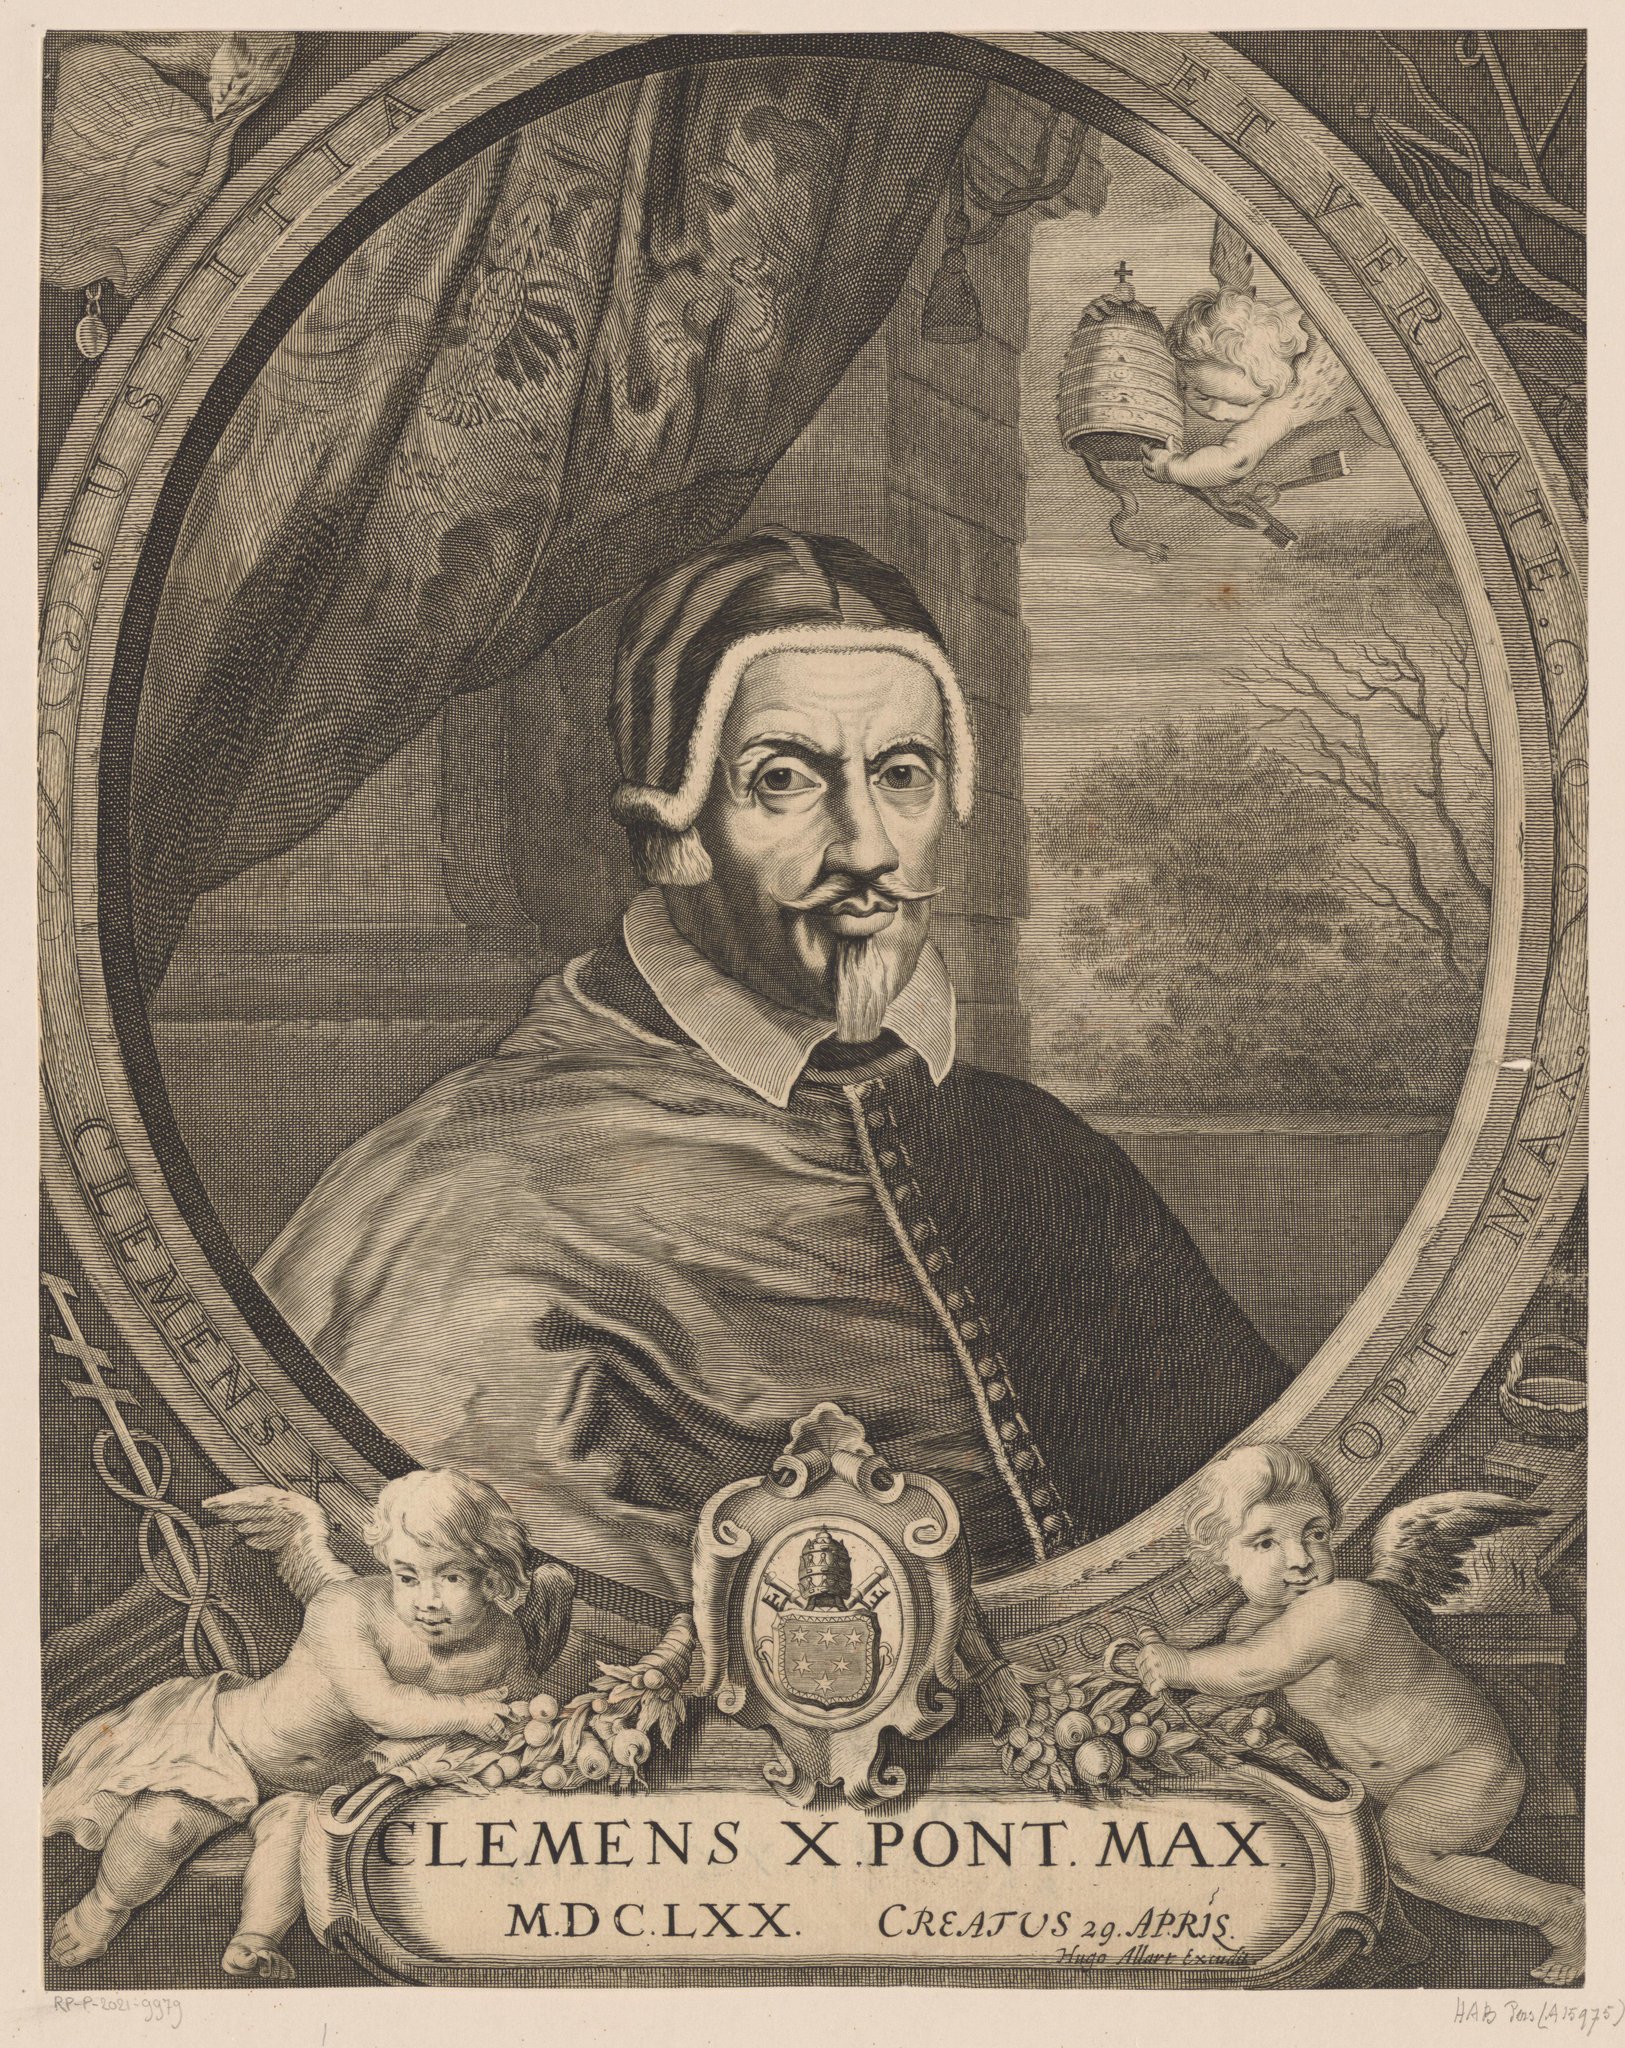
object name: print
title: Portret van Clemens X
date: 1670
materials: paper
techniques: engraving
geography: amsterdam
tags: clemens x, pope - pp - antipope, historical persons, pope, cupids: 'amores', 'amoretti', 'putti', armorial bearing, heraldry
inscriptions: date